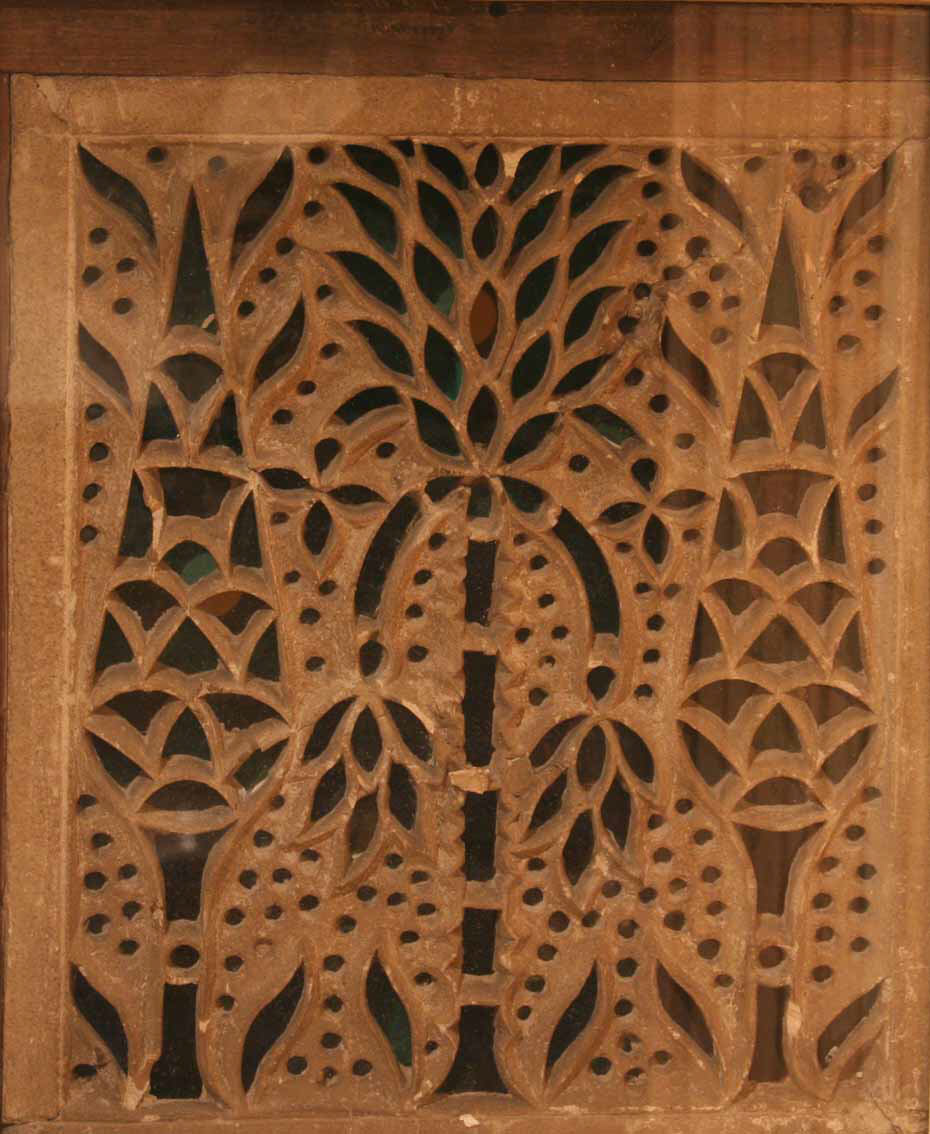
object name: window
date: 1701-1800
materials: gypsum, glass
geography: egypt or syria